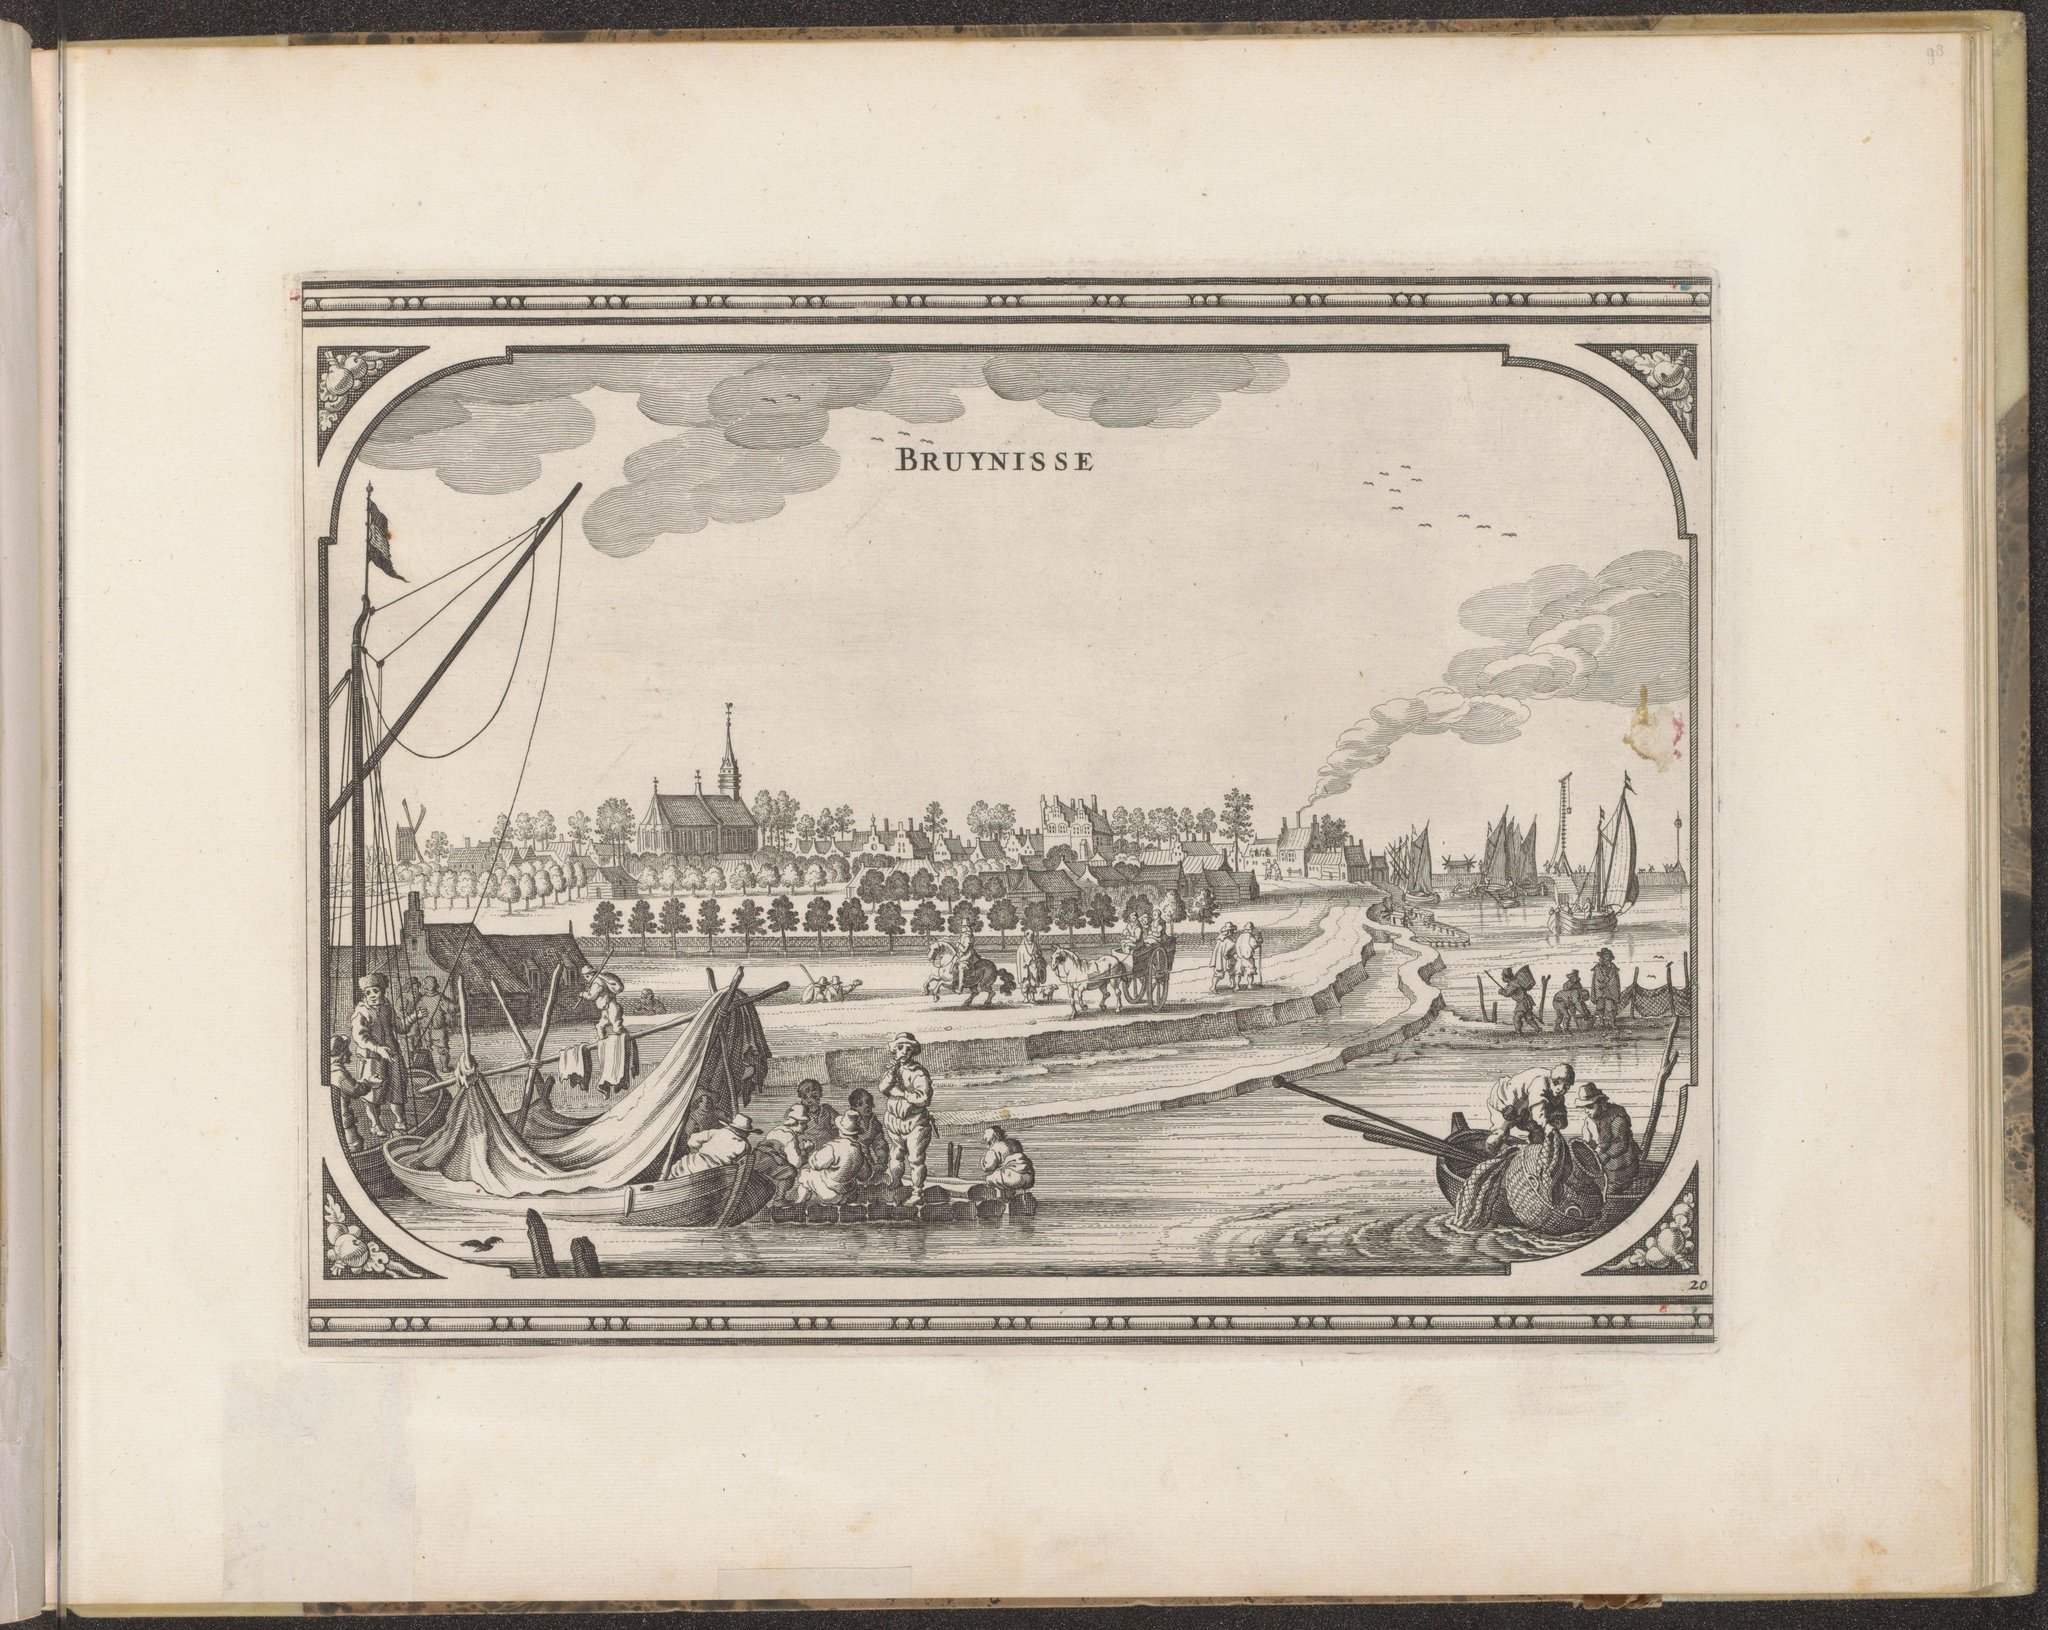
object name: print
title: Bruynisse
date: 1662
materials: paper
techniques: etching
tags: city-view, and landscape with man-made constructions, pipe ~ tobacco, fisherman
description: Gezicht op de stad Bruinisse. Rechts op de voorgrond halen twee mannen een eendenkooi of fuik uit het water. Links bij een boot zit een groep mannen. Eén van de mannen rookt een pijp. De prent maakt deel uit van een album.